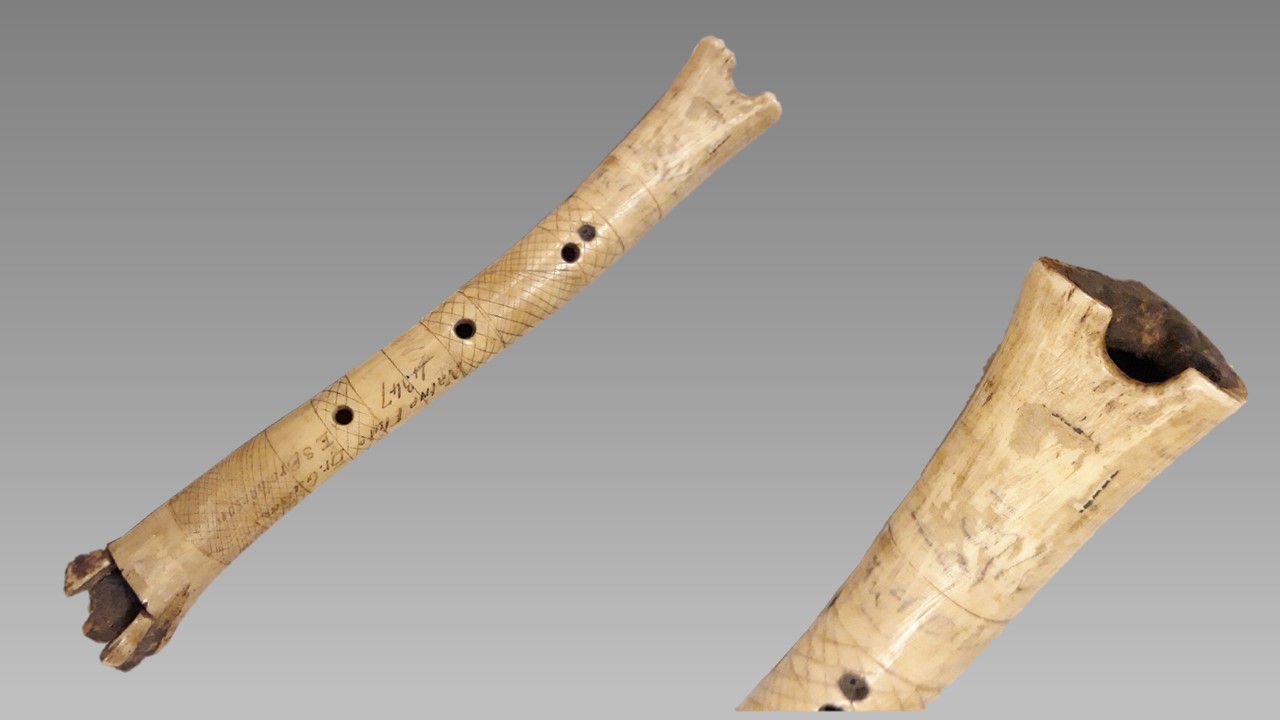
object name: wat sa pua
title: Wat-Sa-Pua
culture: native american or guyanese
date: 1801-1900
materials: bone, wax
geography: guyana